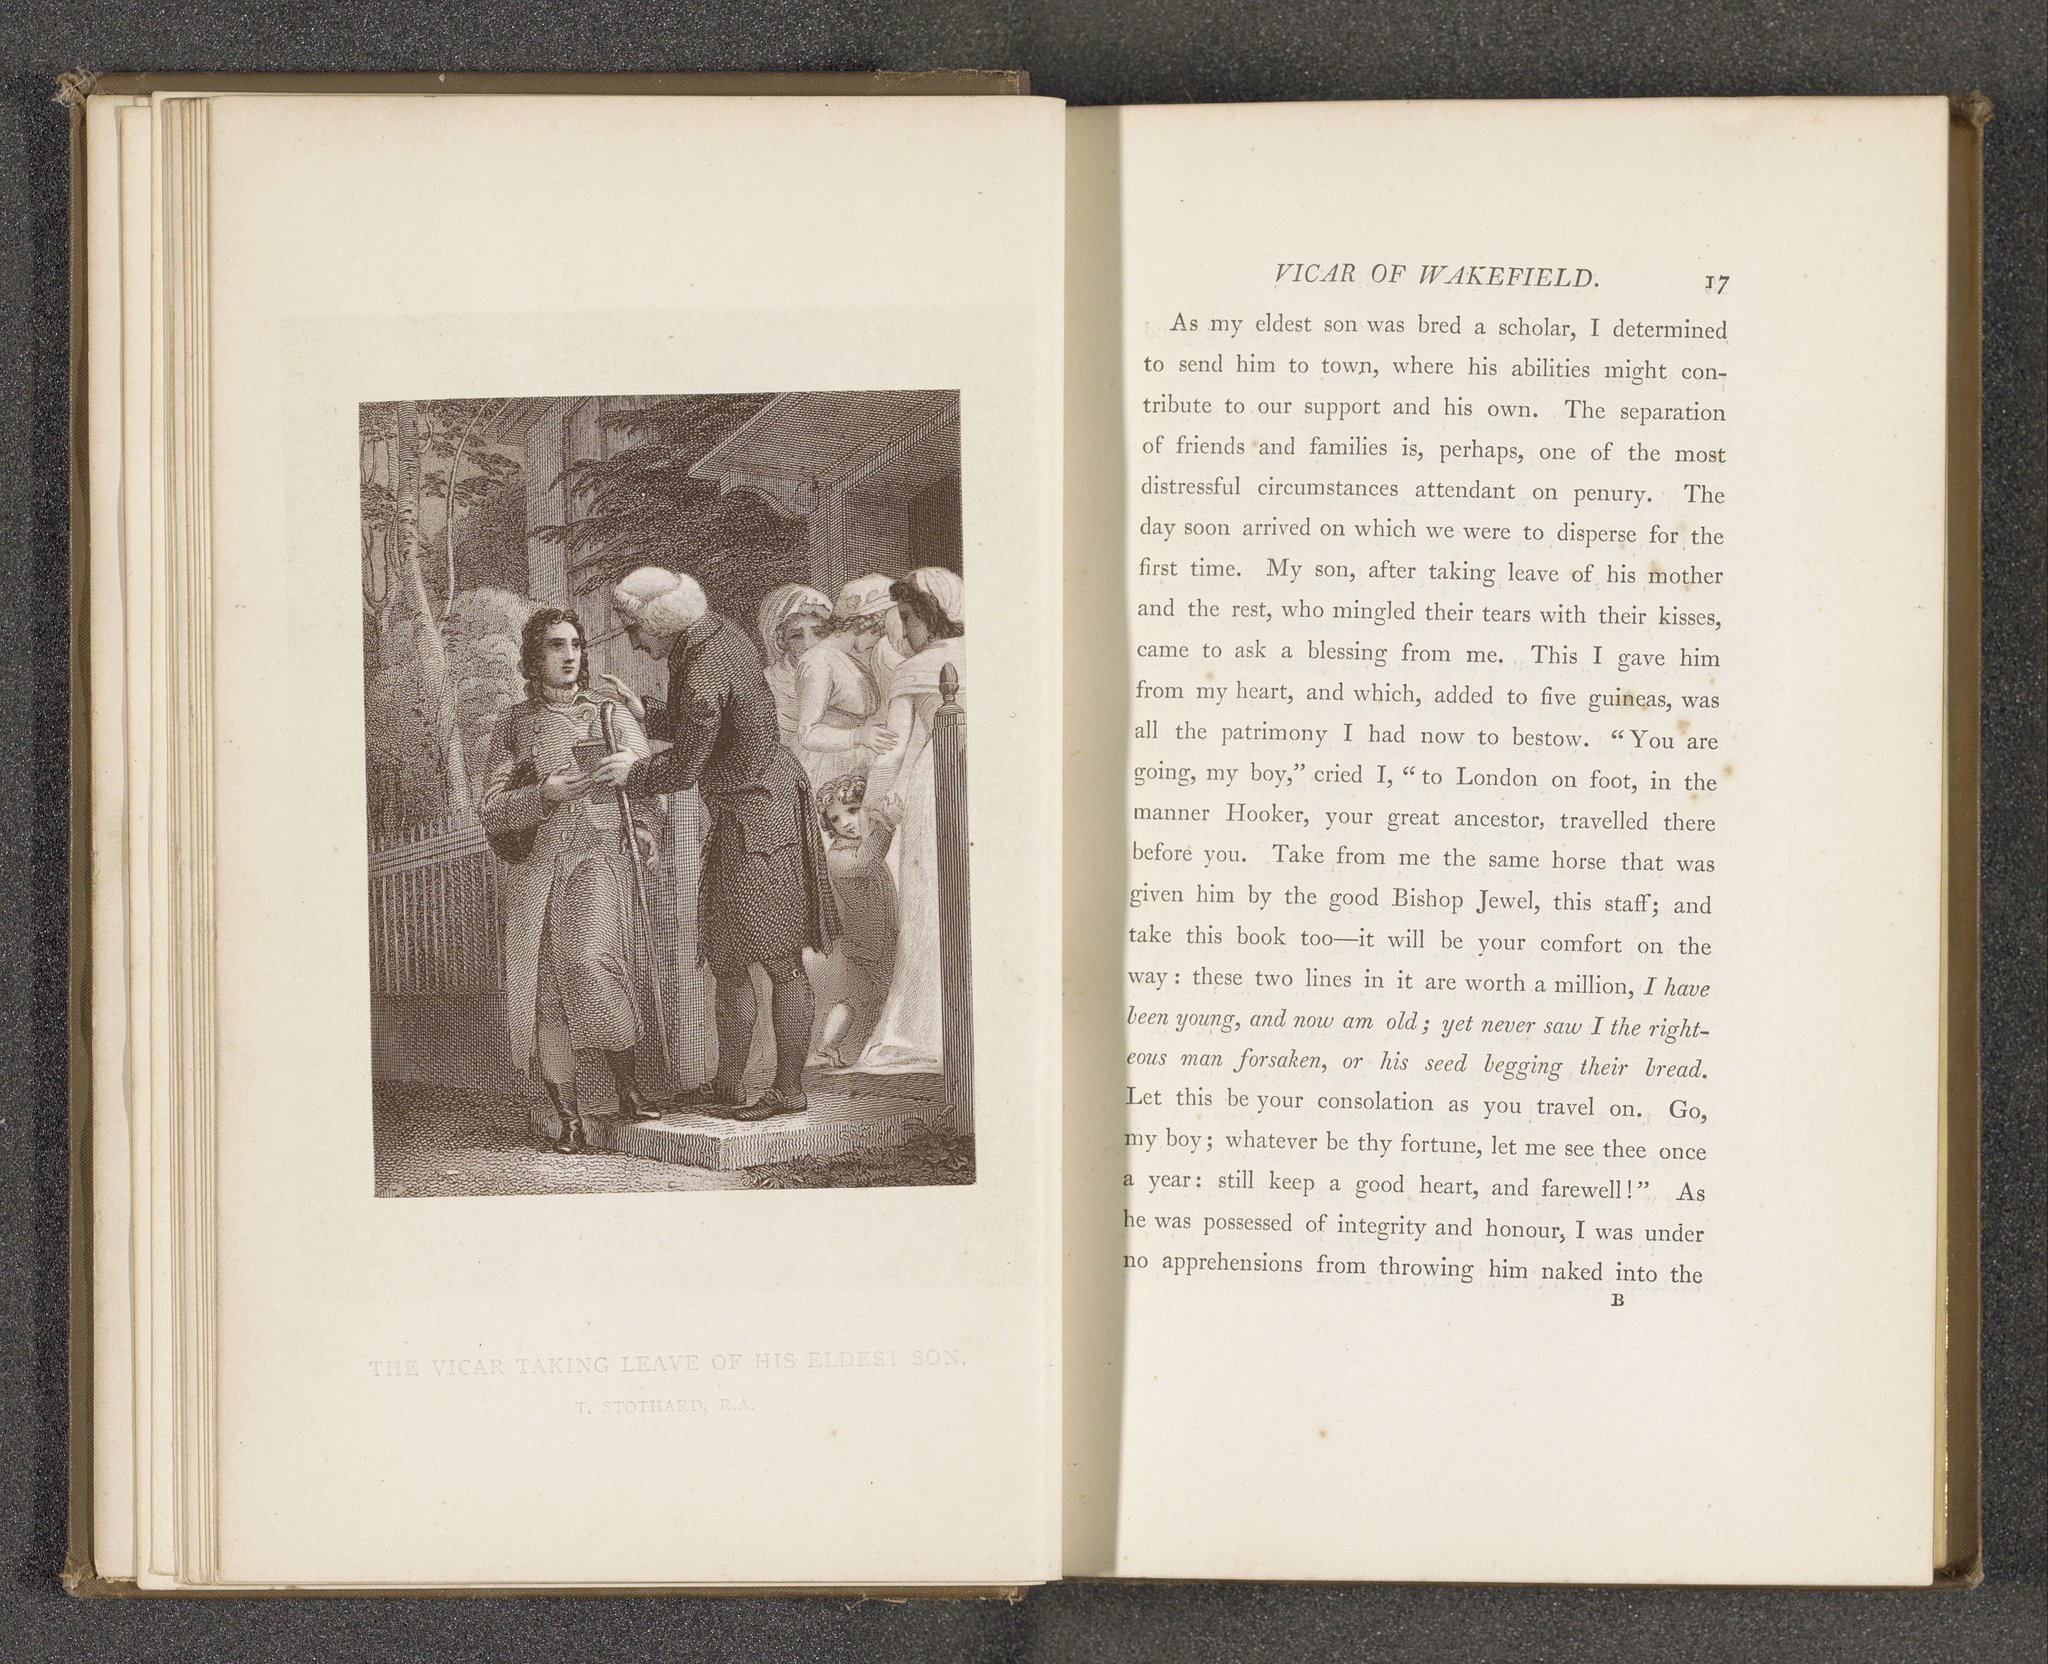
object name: photomechanical print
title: The Vicar taking leave of his eldest Son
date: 1870-1880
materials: paper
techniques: woodburytype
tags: print, e.g.: engraving, etching, lithograph, functionaries and dignitaries ~ episcopal protestant churches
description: Op de illustratie neemt de vicaris afscheid van zijn oudste zoon.